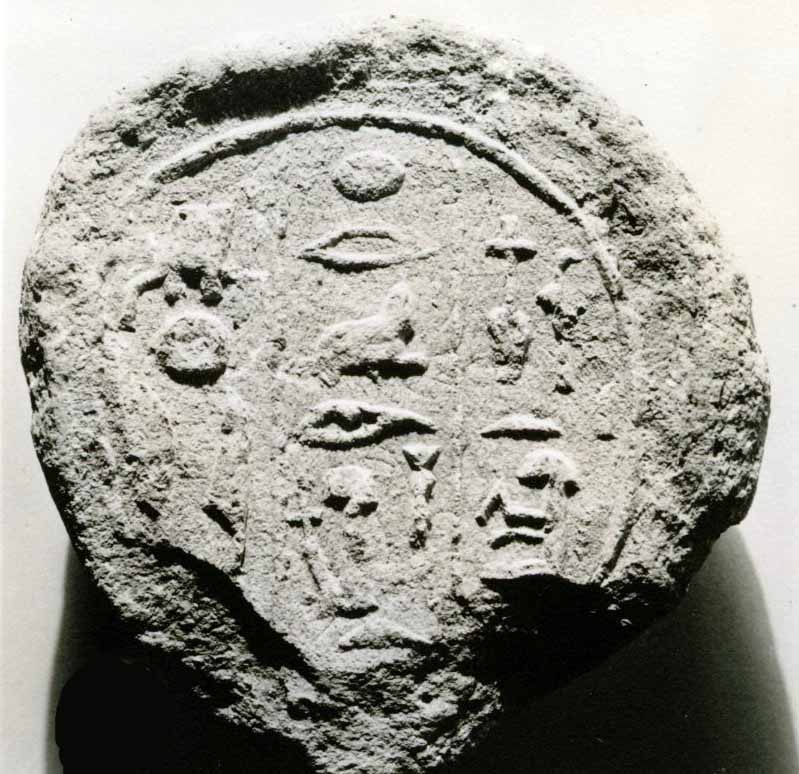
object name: cone, neferrenpet, circular impression, keeper, date wine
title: Funerary Cone of the Keeper of the Date Wine Neferrenpet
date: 1550-1295 BCE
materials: pottery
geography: egypt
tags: hieroglyphs